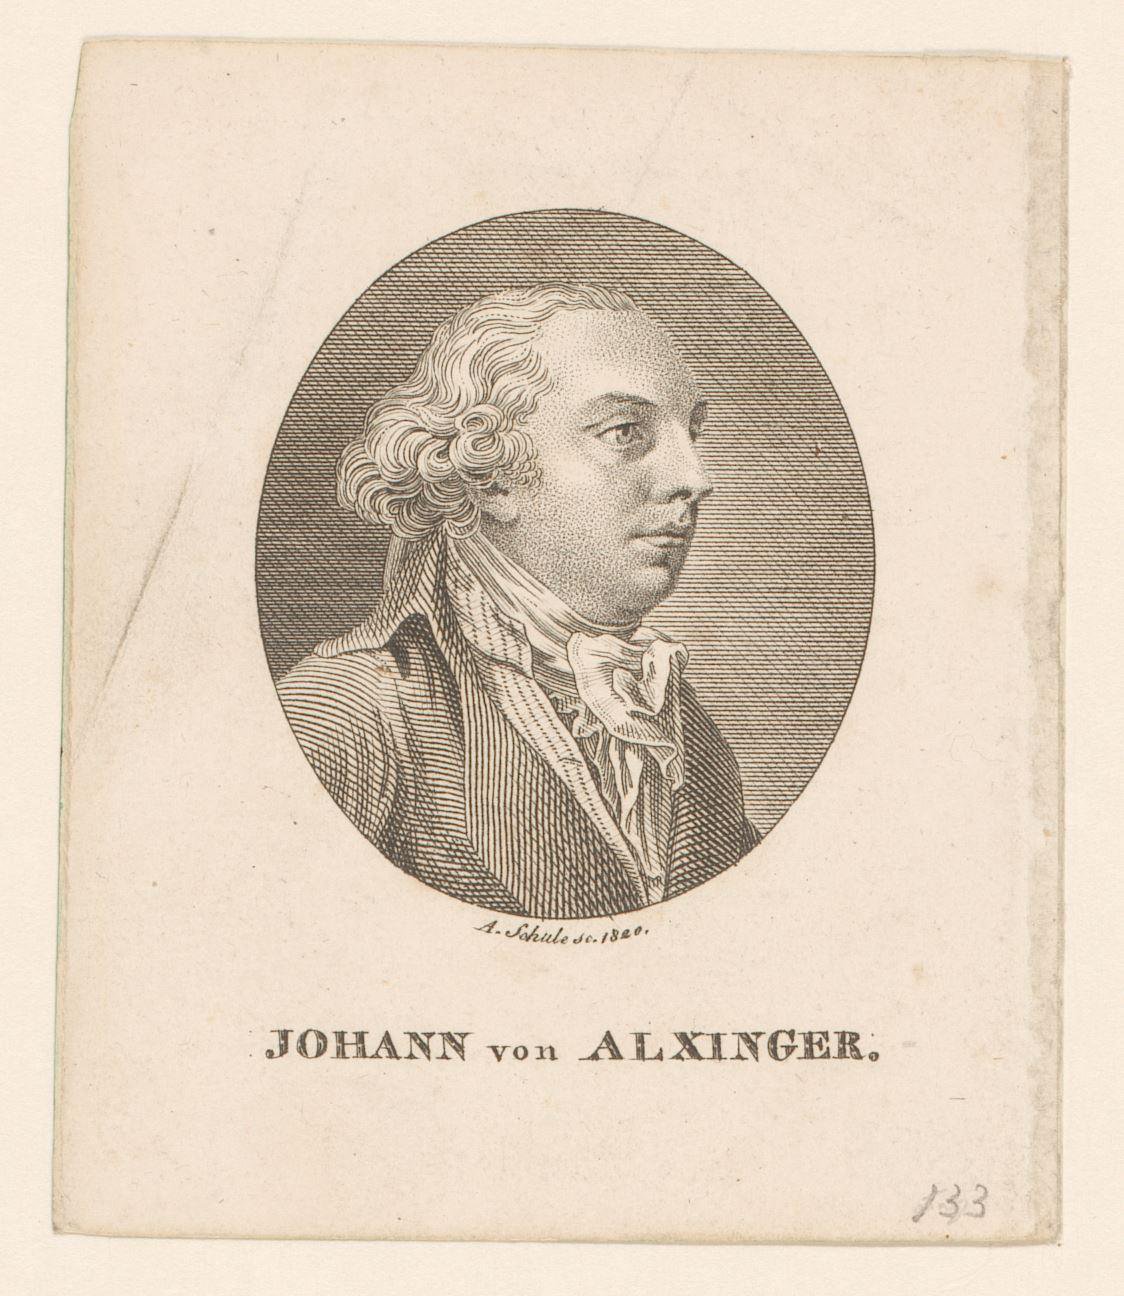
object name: print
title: Portret van Johann Baptist Edler von Alxinger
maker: albert schule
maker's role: painter, print maker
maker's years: 1801-1875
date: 1820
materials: paper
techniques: engraving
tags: historical persons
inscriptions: collector's mark: Lugt 2228